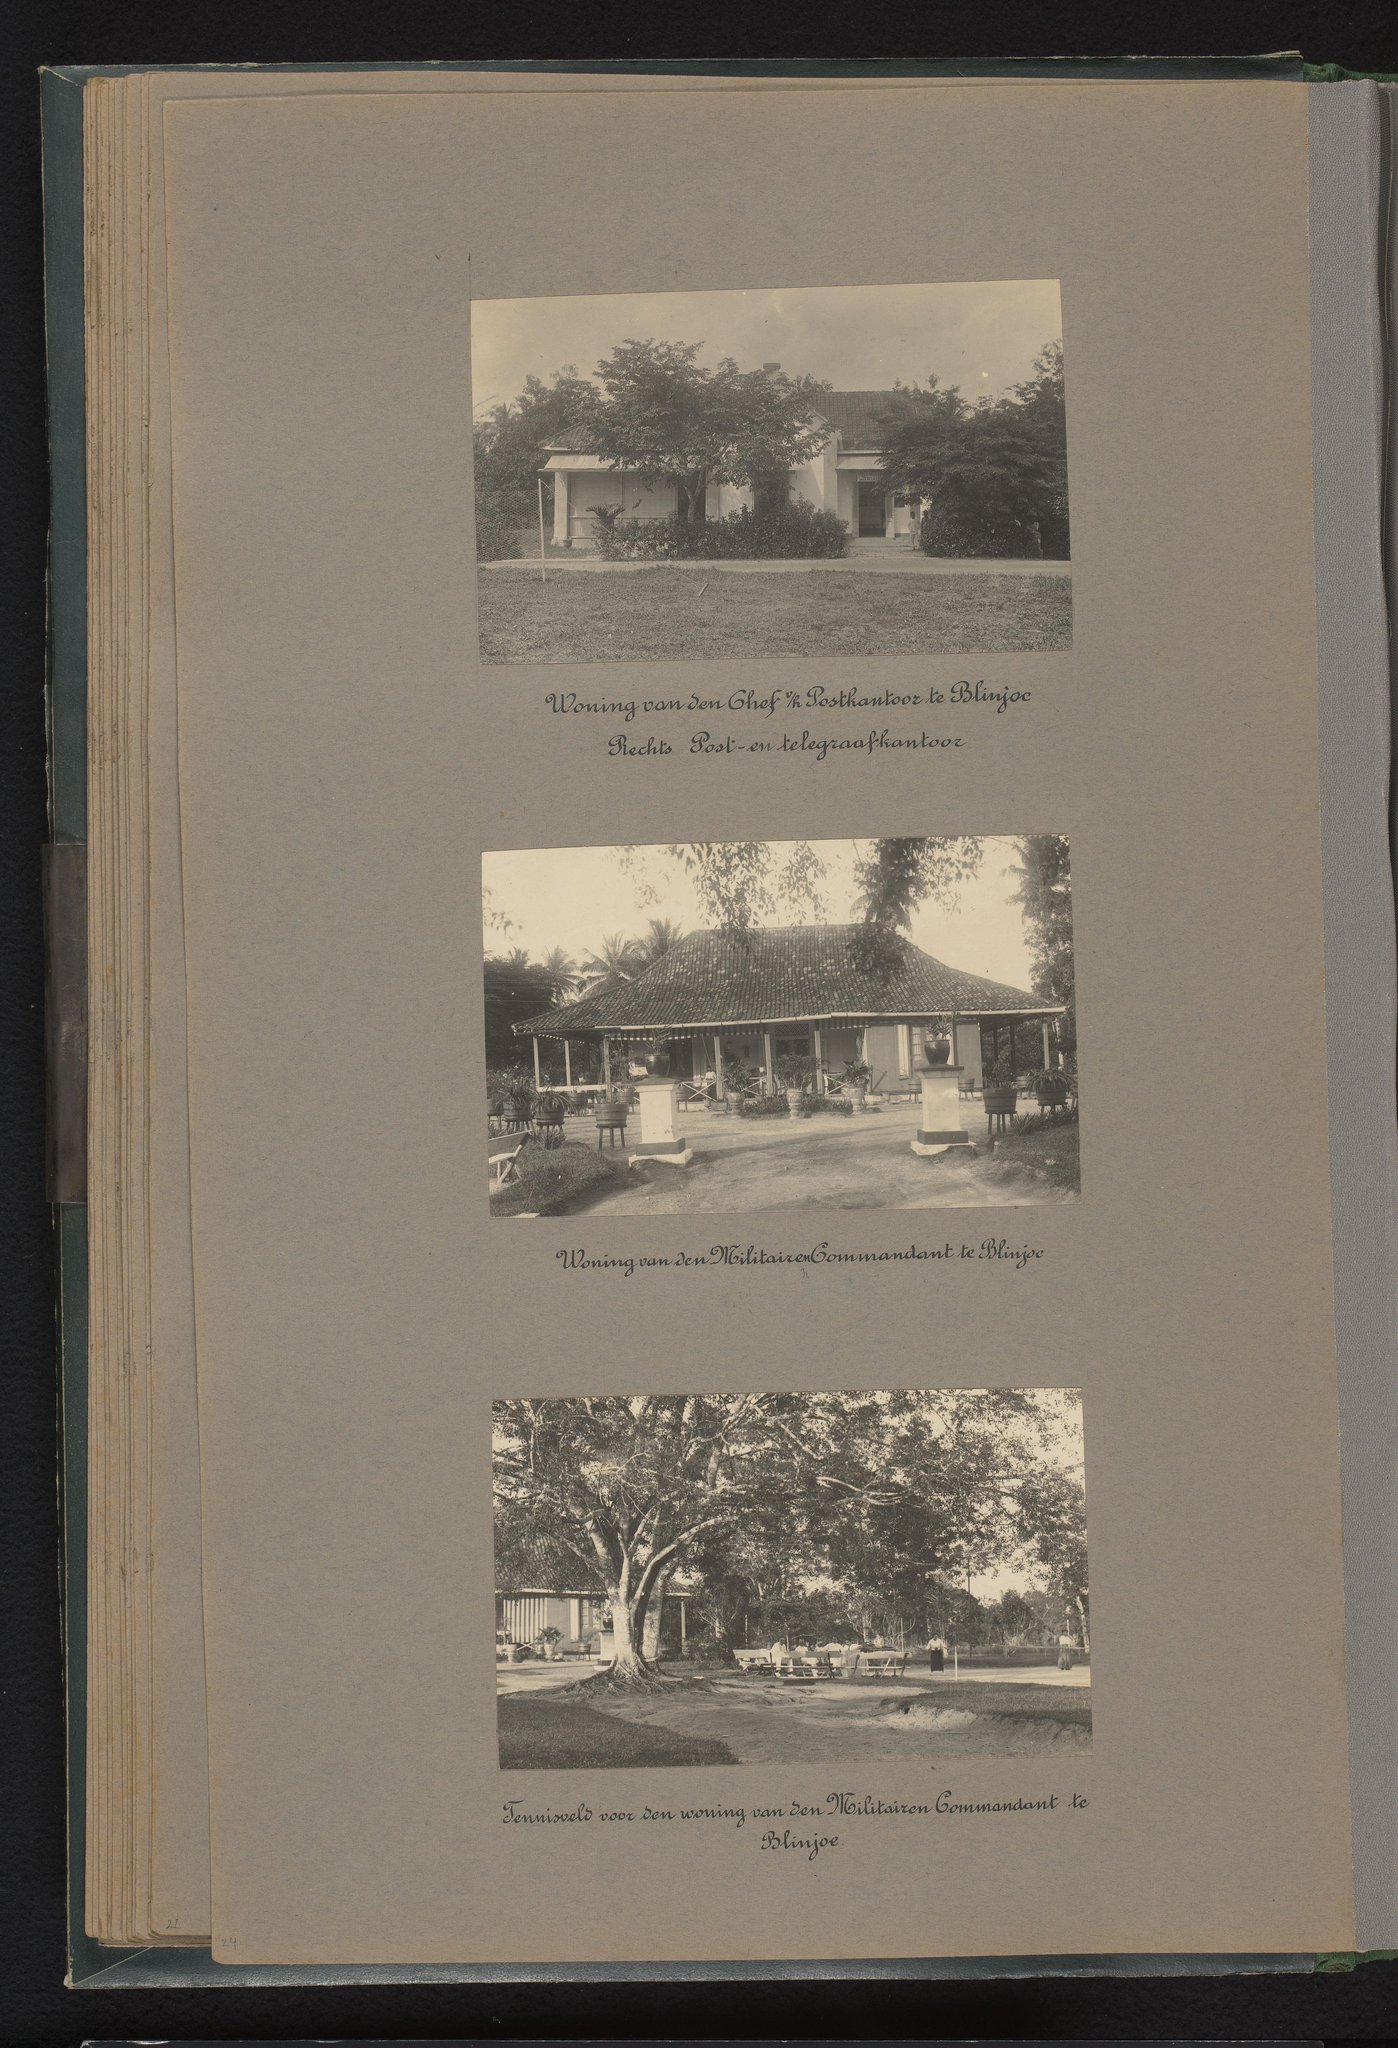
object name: photograph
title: Woningen en tennisbaan van de Banka-tinwinning te Blinjoe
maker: Anonymous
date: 1914-1919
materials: cardboard, photographic support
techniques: gelatin silver print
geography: bangka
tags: robert julius boers, colonial system, mining, tennis, lawn-tennis, villa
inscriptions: inscription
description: Albumblad met drie foto's van woningen van hoger personeel van de Banka-tinwinning en de tennisbaan te Blinjoe. Onderdeel van het fotoalbum aangeboden aan Robert Julius Boers bij zijn vertrek naar Nederland in 1919 door het personeel van de Banka-tinwinning.